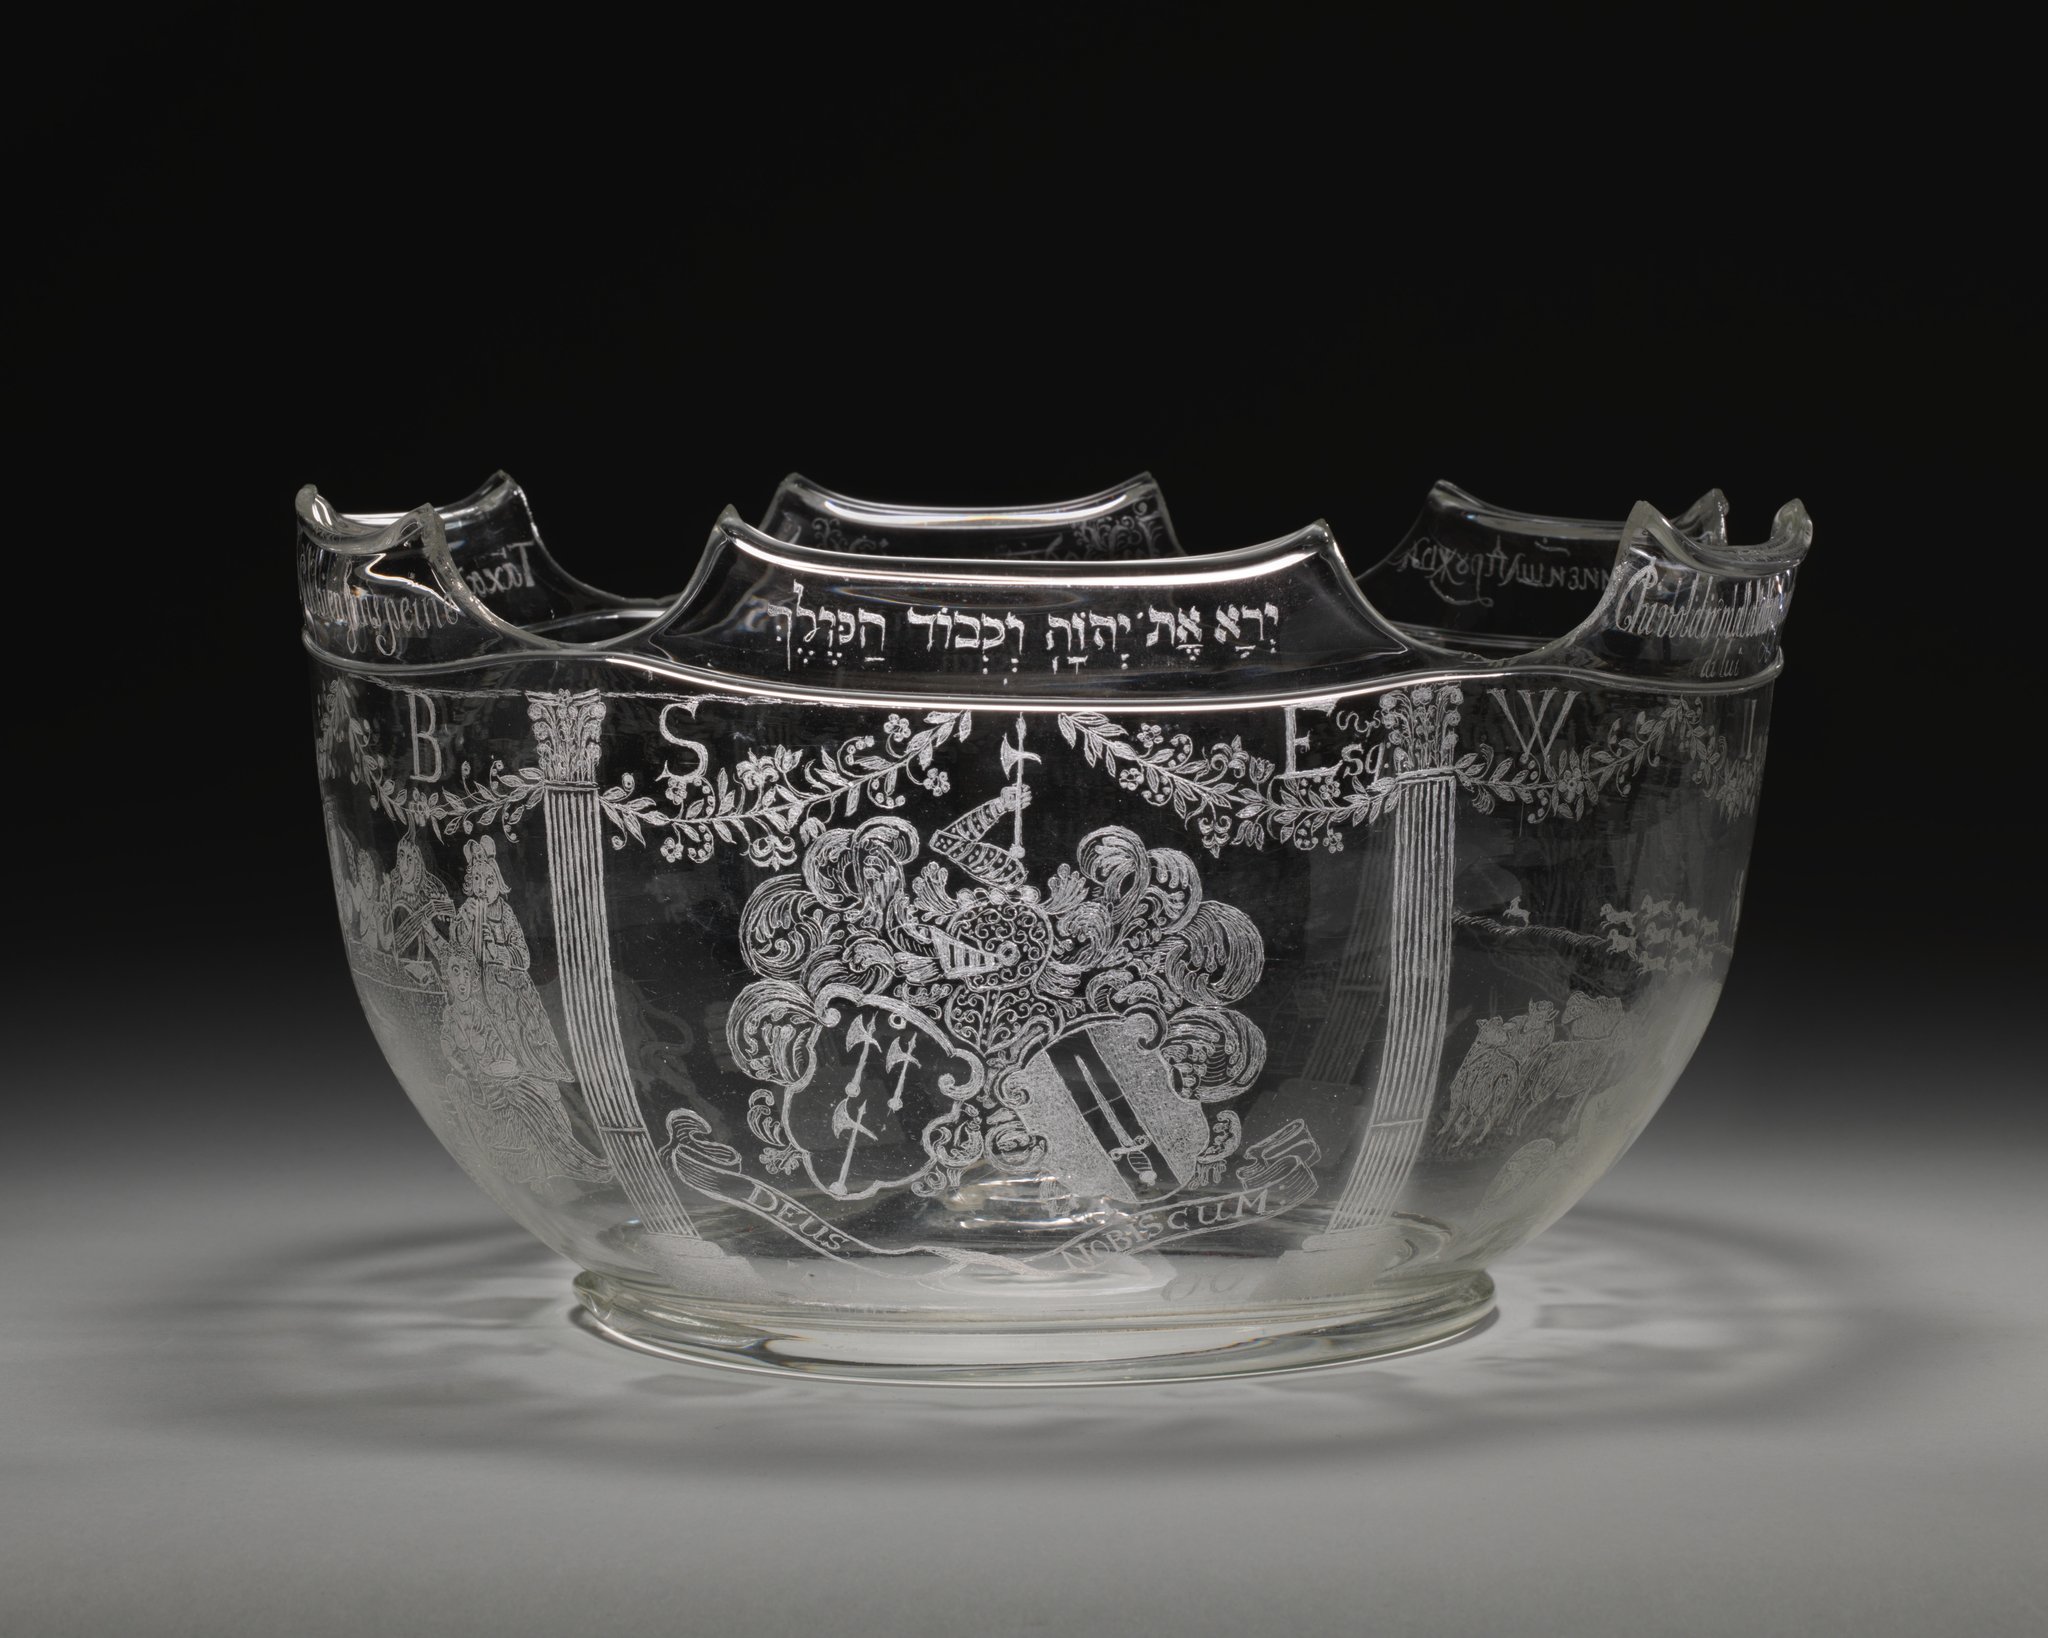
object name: monteith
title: Monteith with the Gibbs and Nelthorpe coats of arms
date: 1700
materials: glass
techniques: engraving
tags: birds,cupid,cows,sheep,coat of arms,musicians